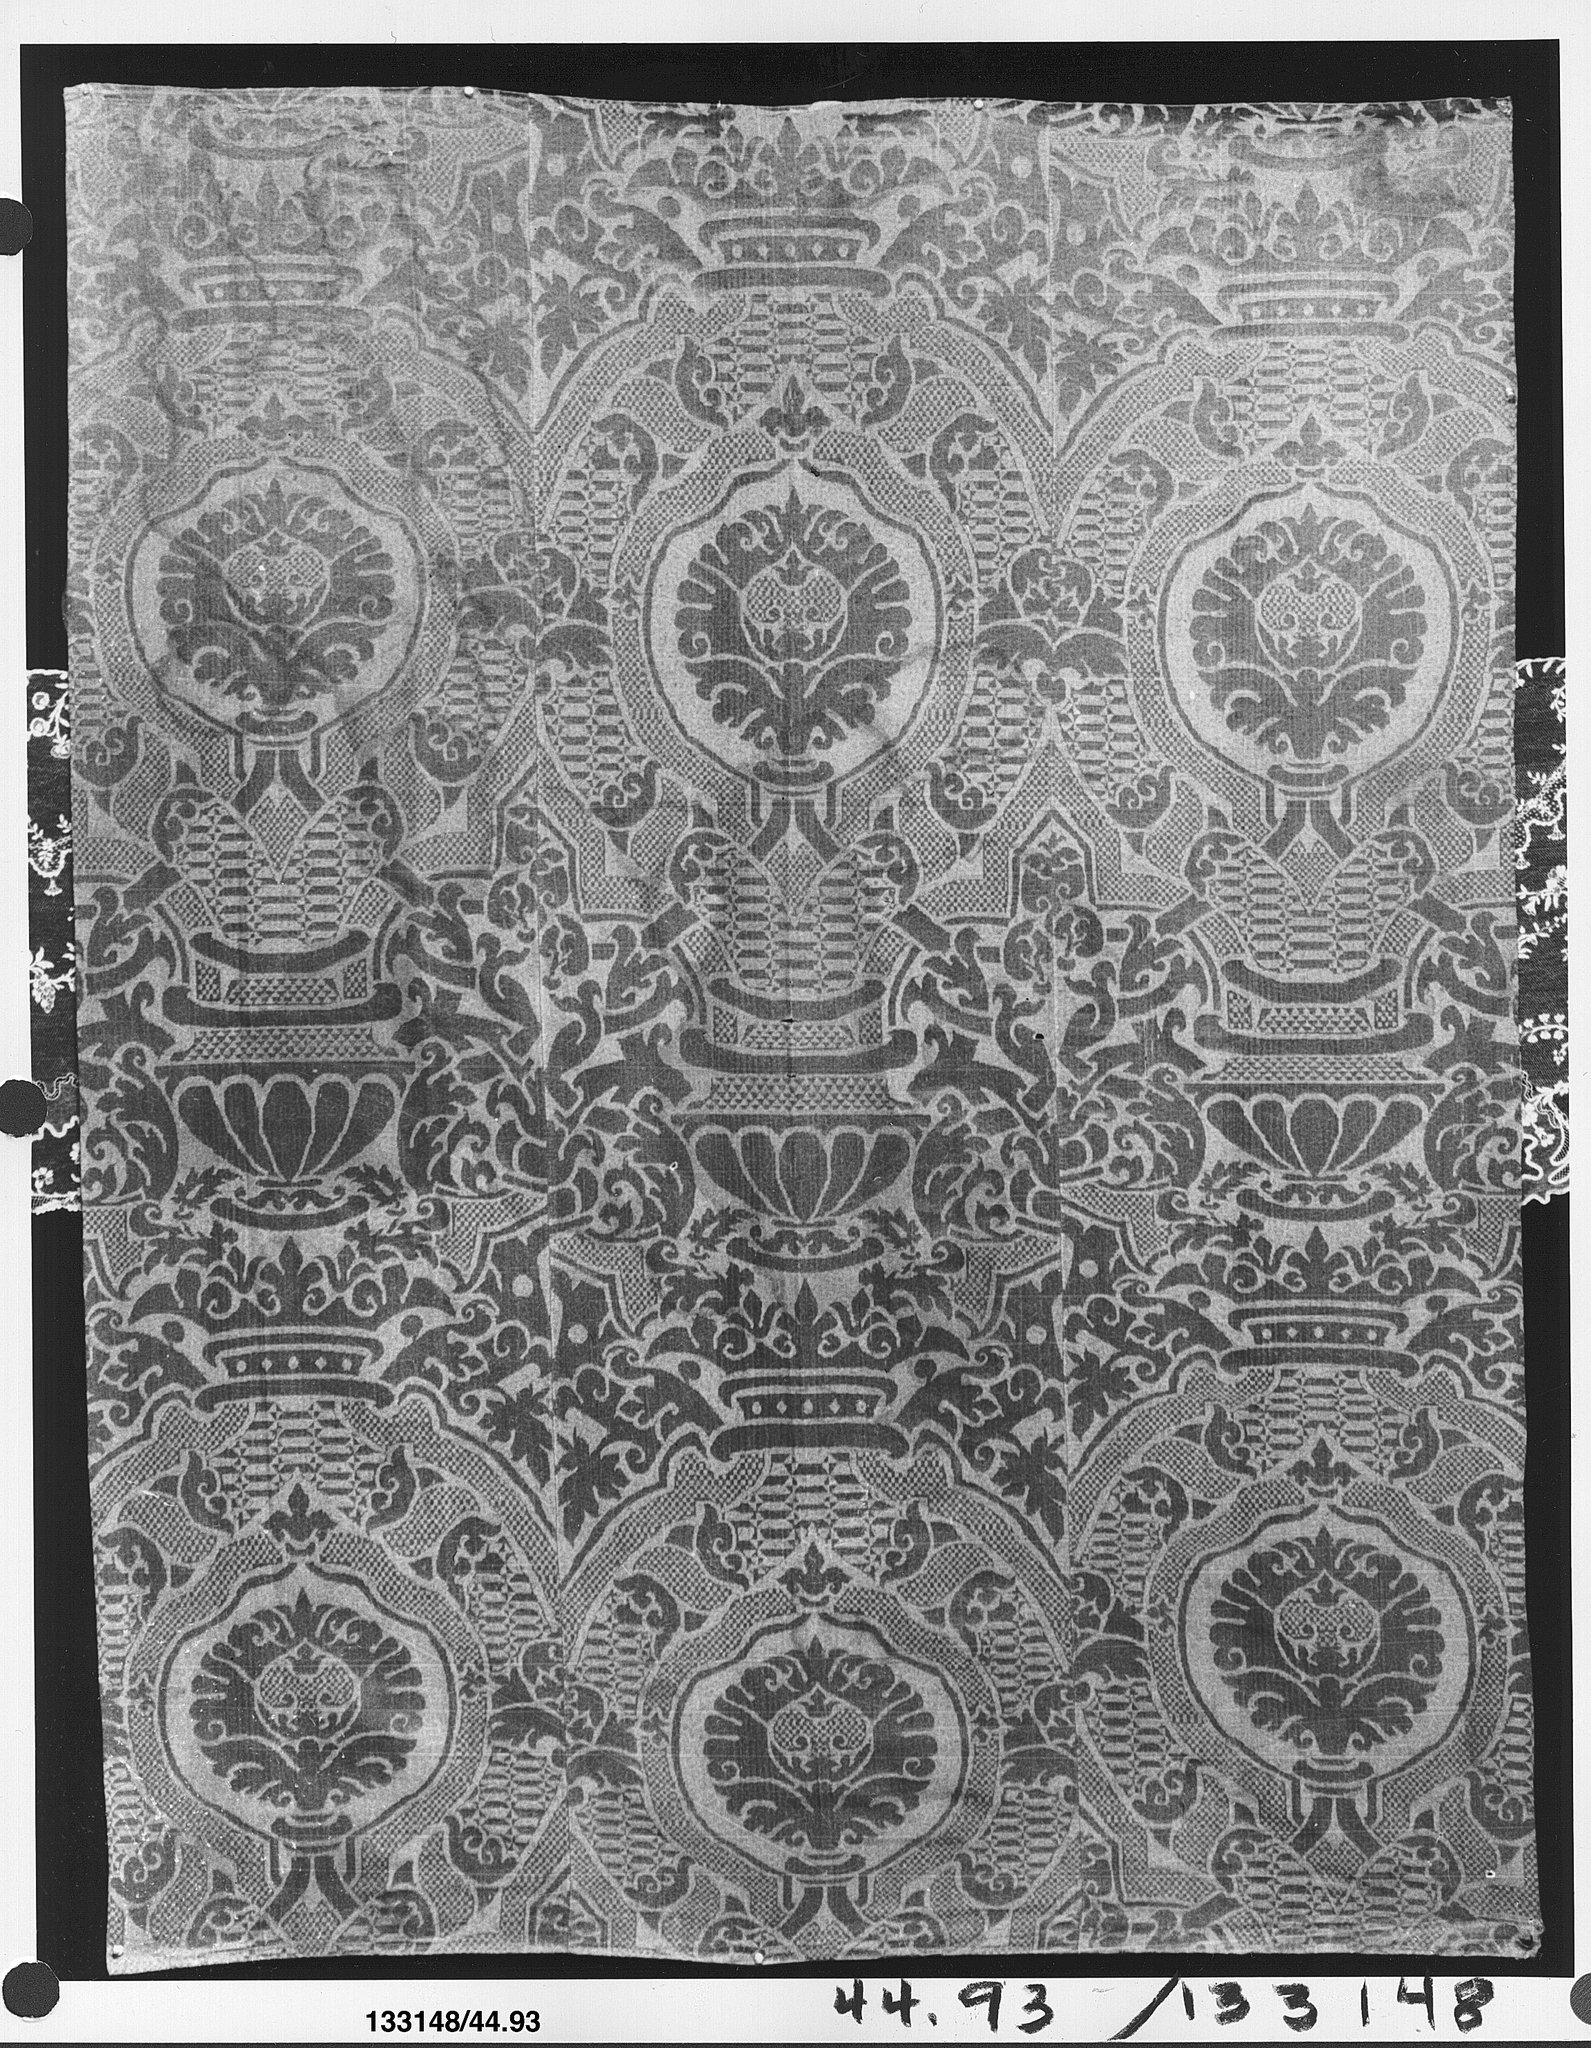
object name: piece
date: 1601-1700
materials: silk